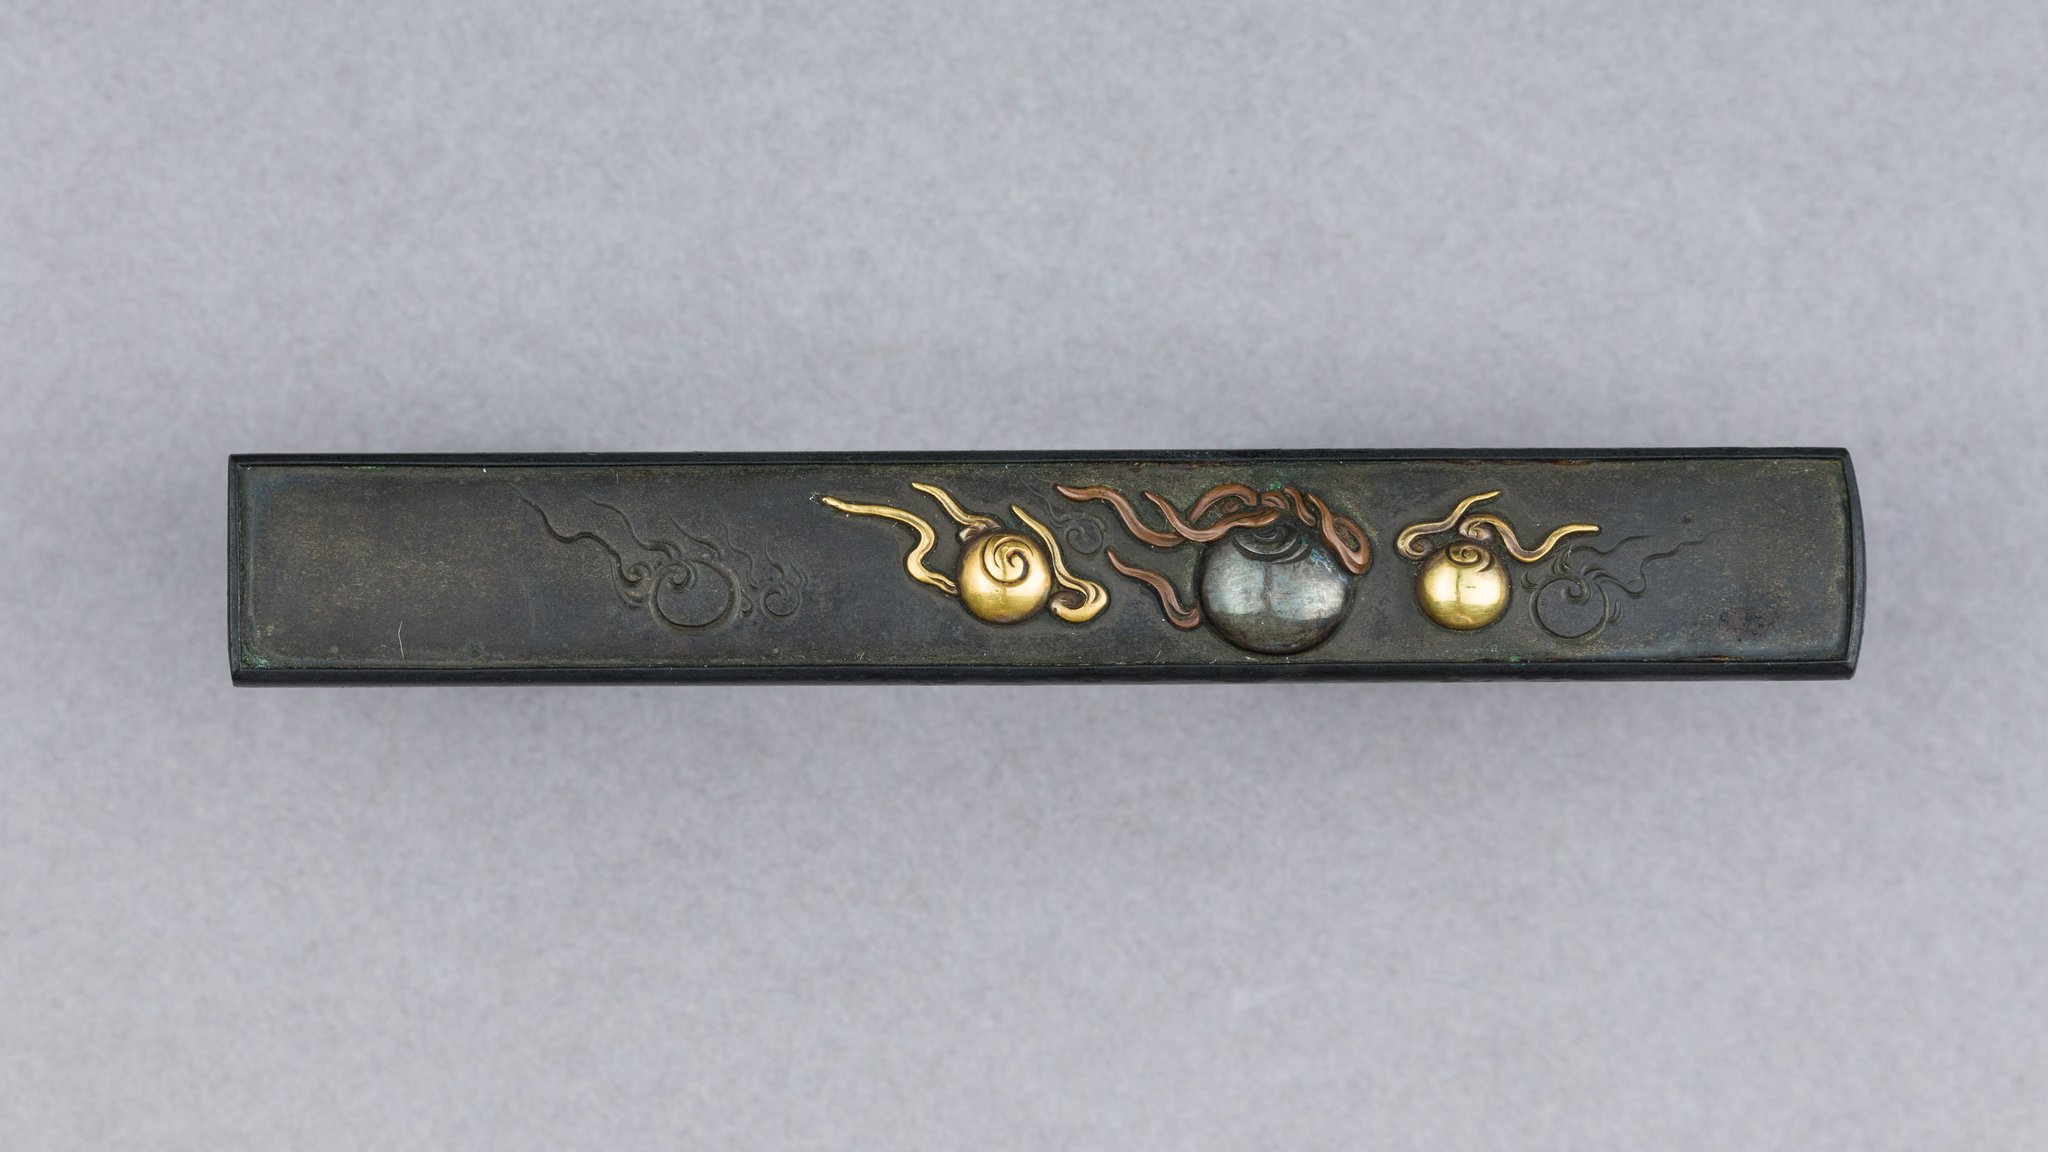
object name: knife handle kozuka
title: Knife Handle (Kozuka)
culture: japanese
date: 1701-1800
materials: gold alloy, silver alloy, gold, silver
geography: japan